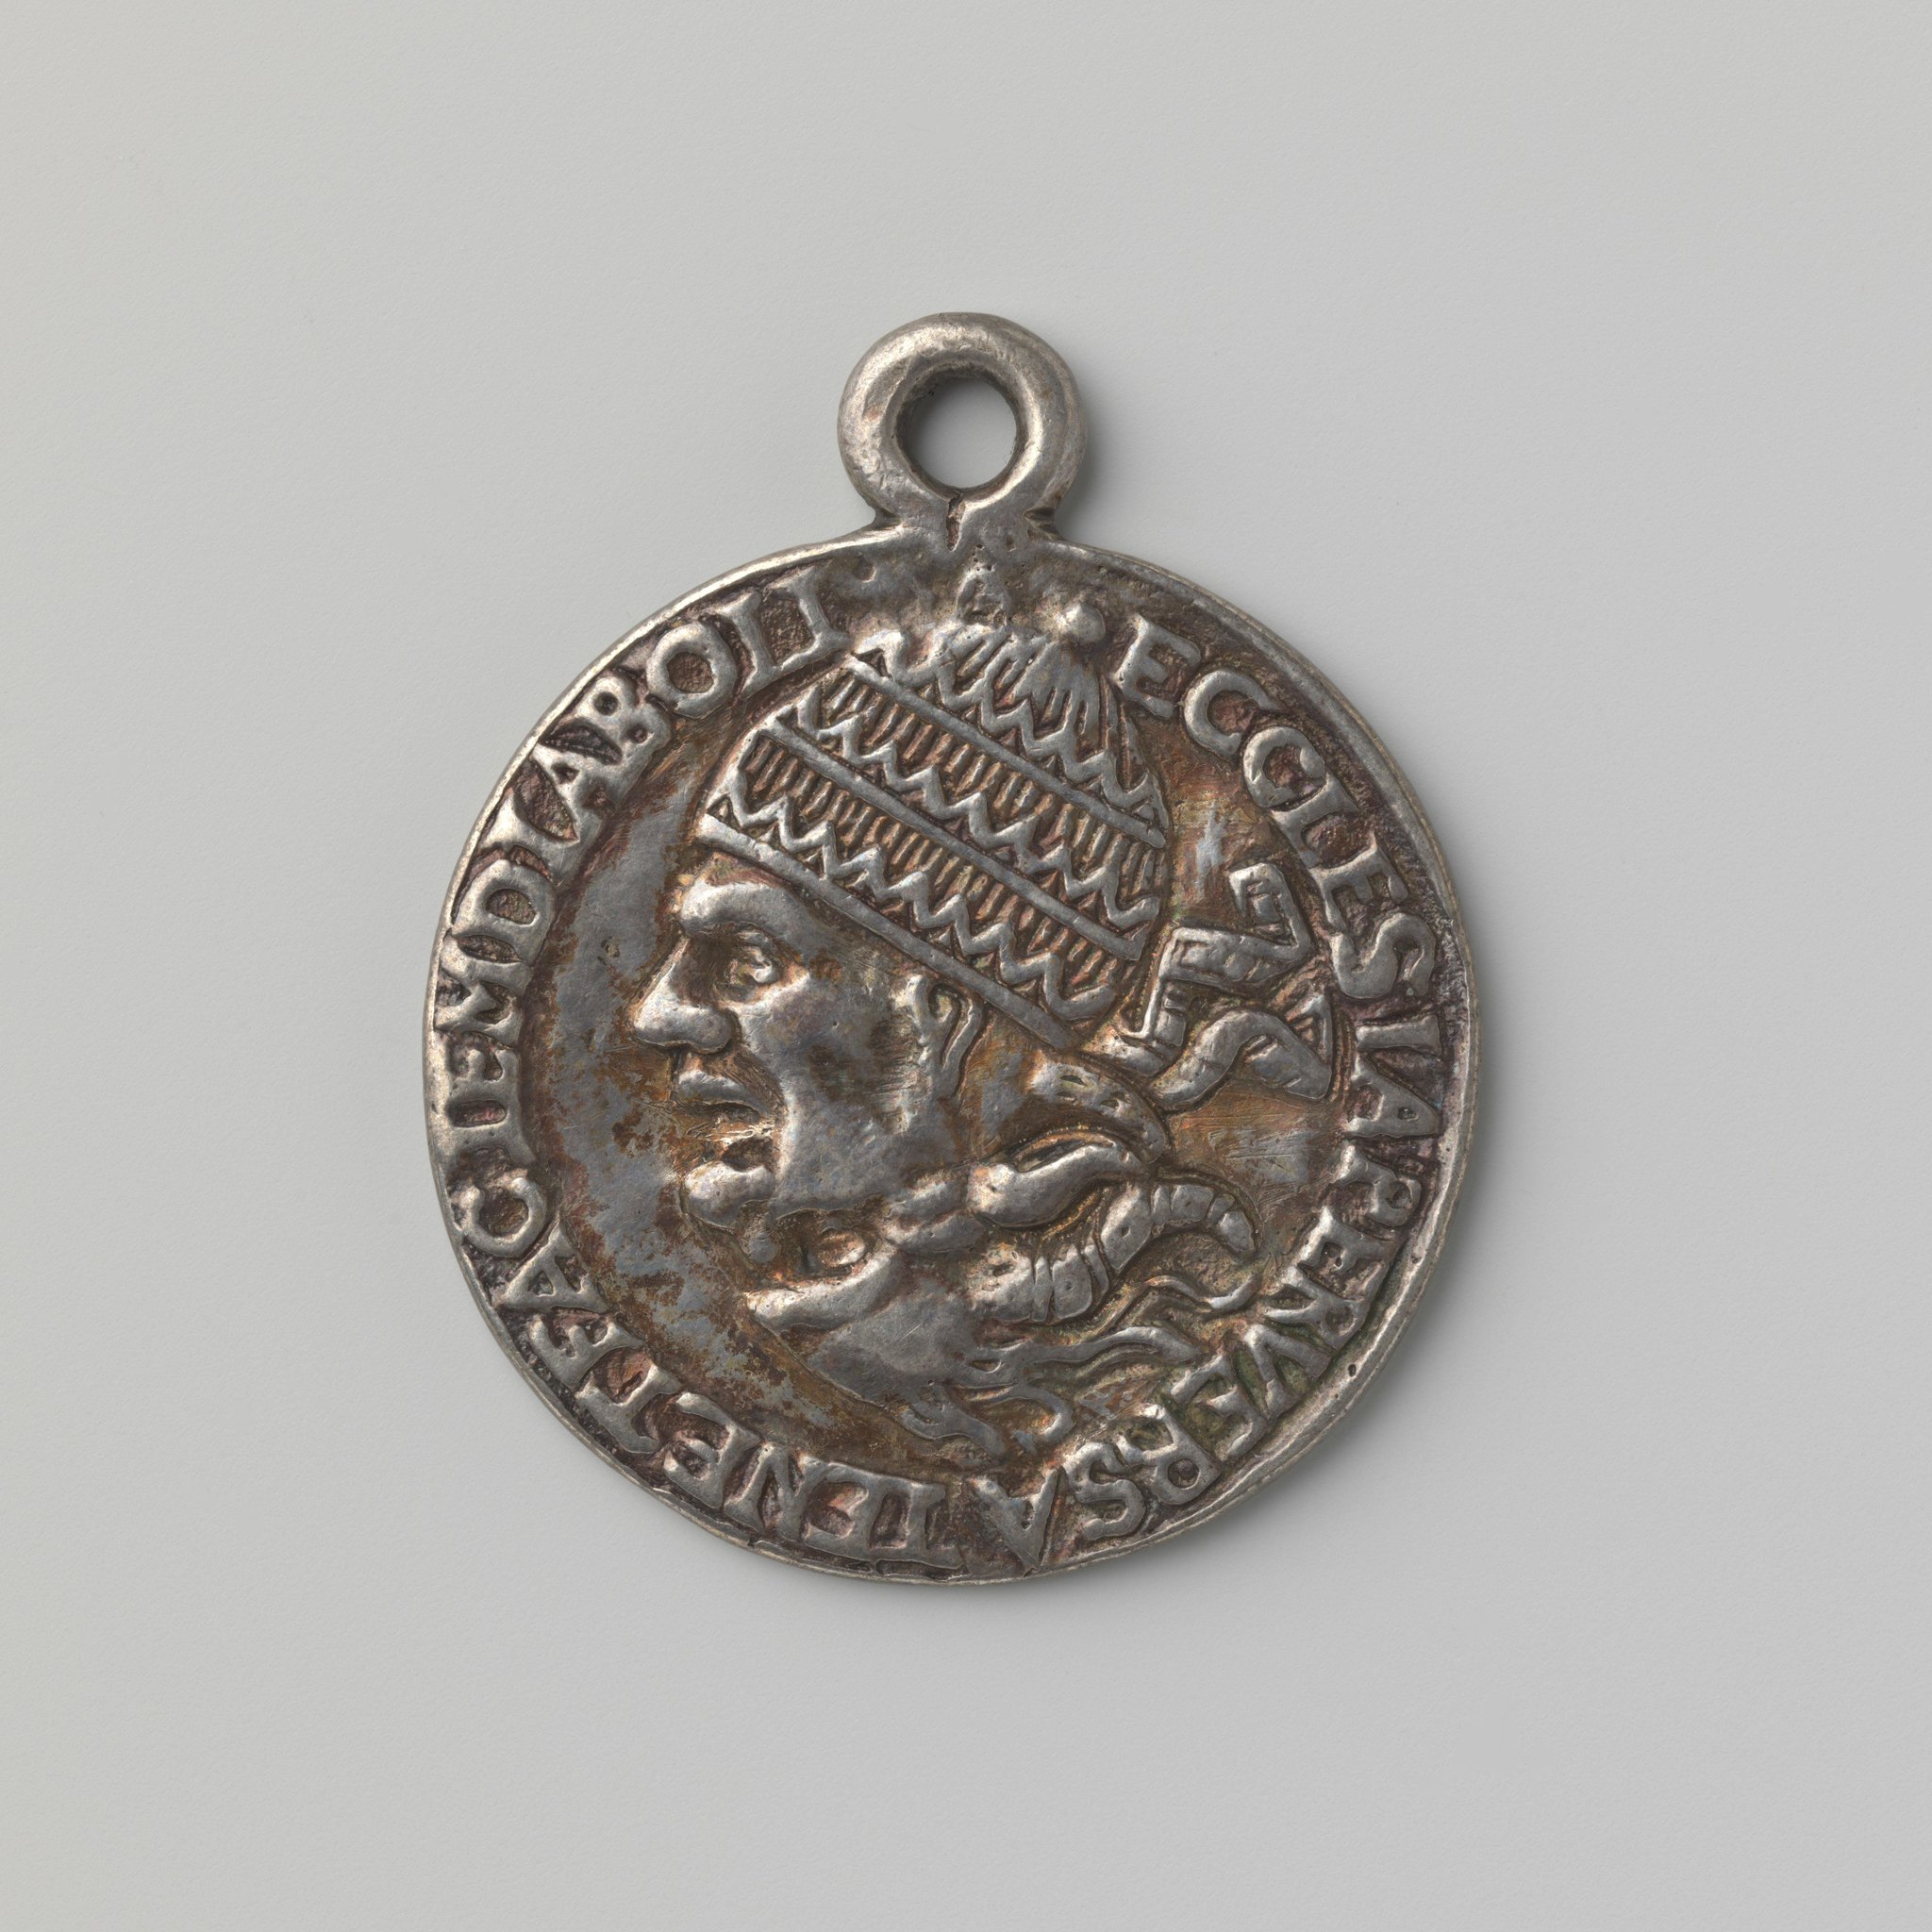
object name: medal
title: Concilie van Trente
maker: Anonymous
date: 1545-1563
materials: silver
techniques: casting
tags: concilie van trente